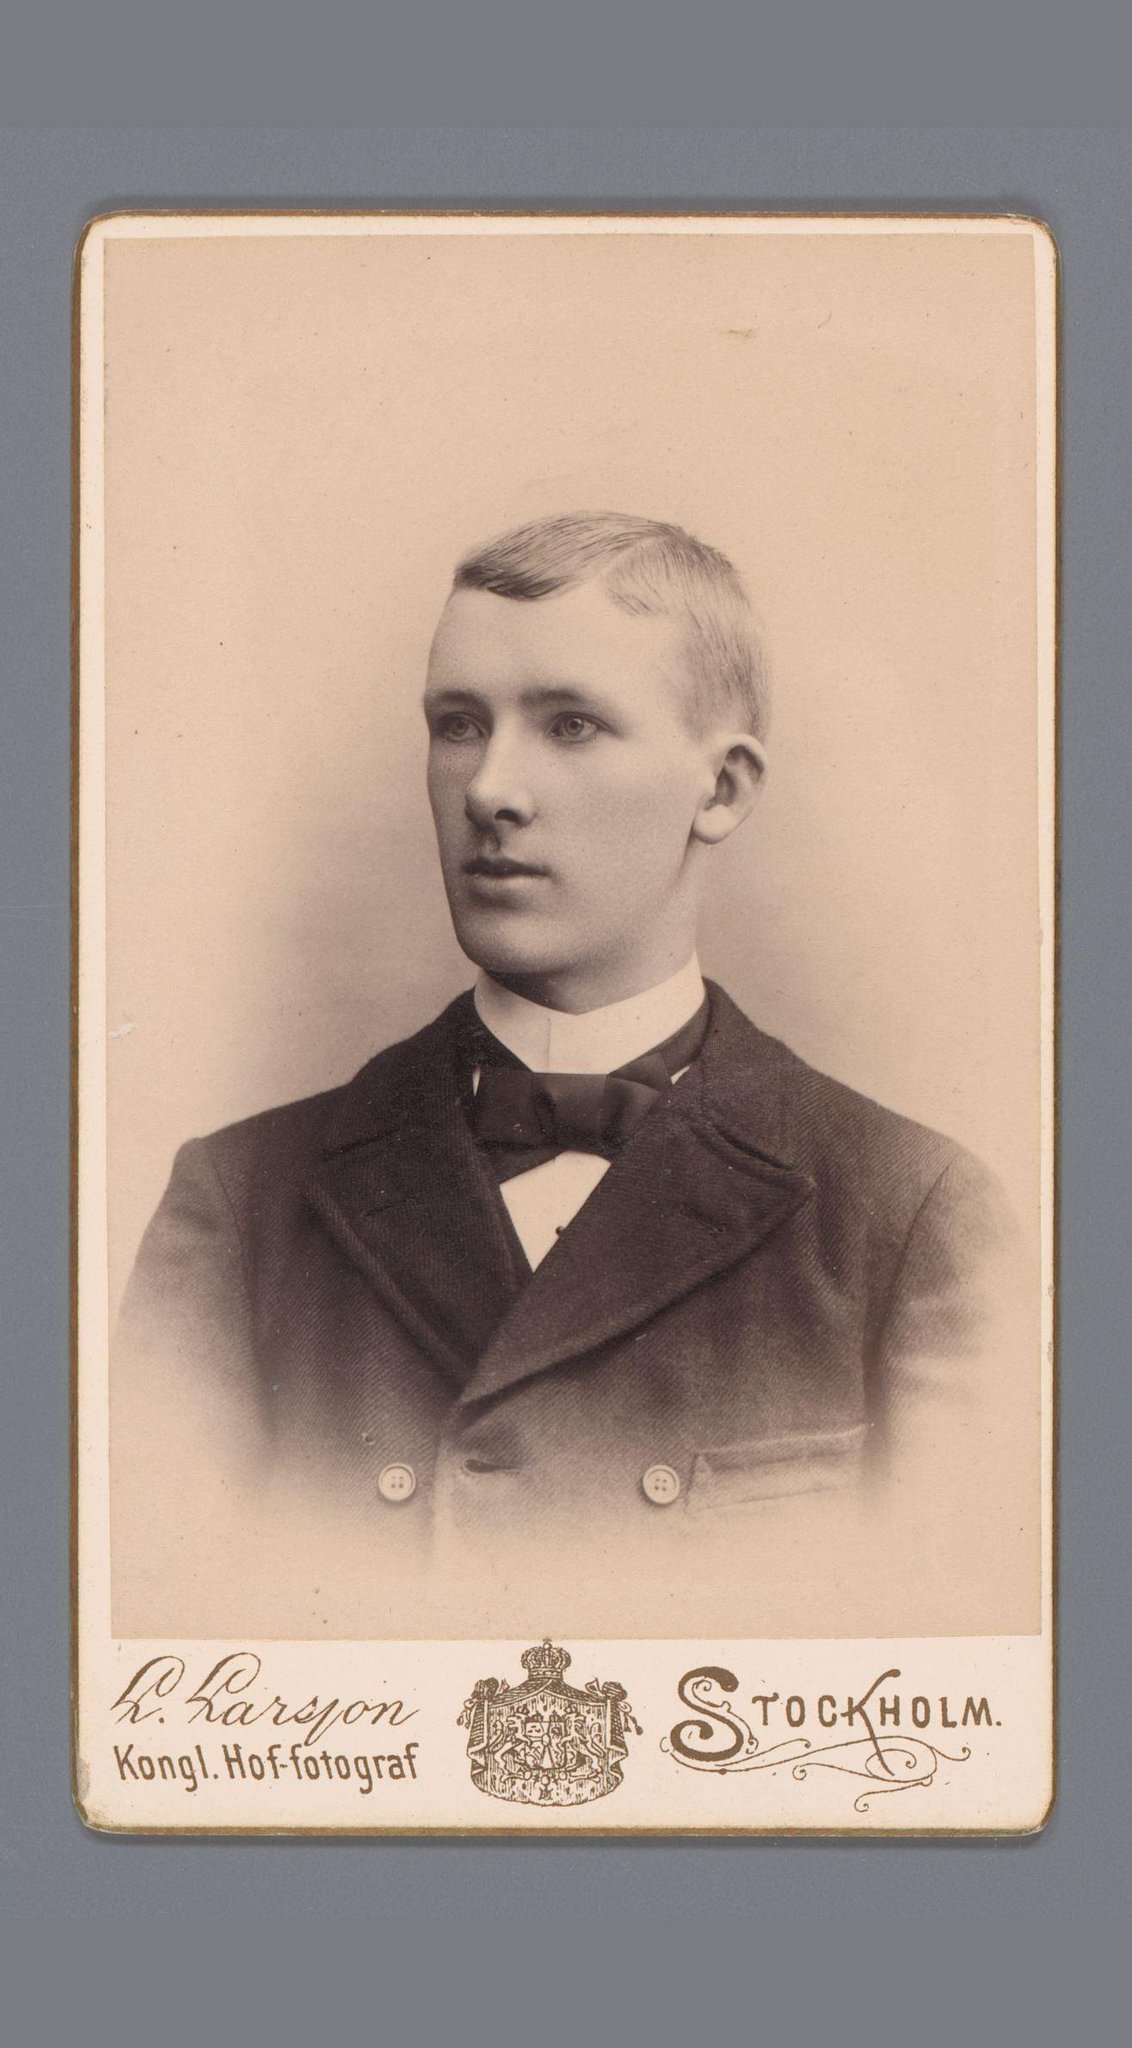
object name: photograph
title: Portret van een onbekende man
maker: landén larsson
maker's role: fotograaf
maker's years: 1866-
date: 1894-1898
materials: cardboard, paper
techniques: albumen print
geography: stockholm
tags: historical persons, youth, adolescent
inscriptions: inscription: ‘KONGL. HOF-FOTOGRAF/ (...)/ 1a Pris./ DIPLOM/ 1894/ Telefon No. 107 13.’, address: ‘STOCKHOLM/ 21 HUMLEGÅRDSGATAN 21/ (hörnet af Sturegatan)/ Nerlien’